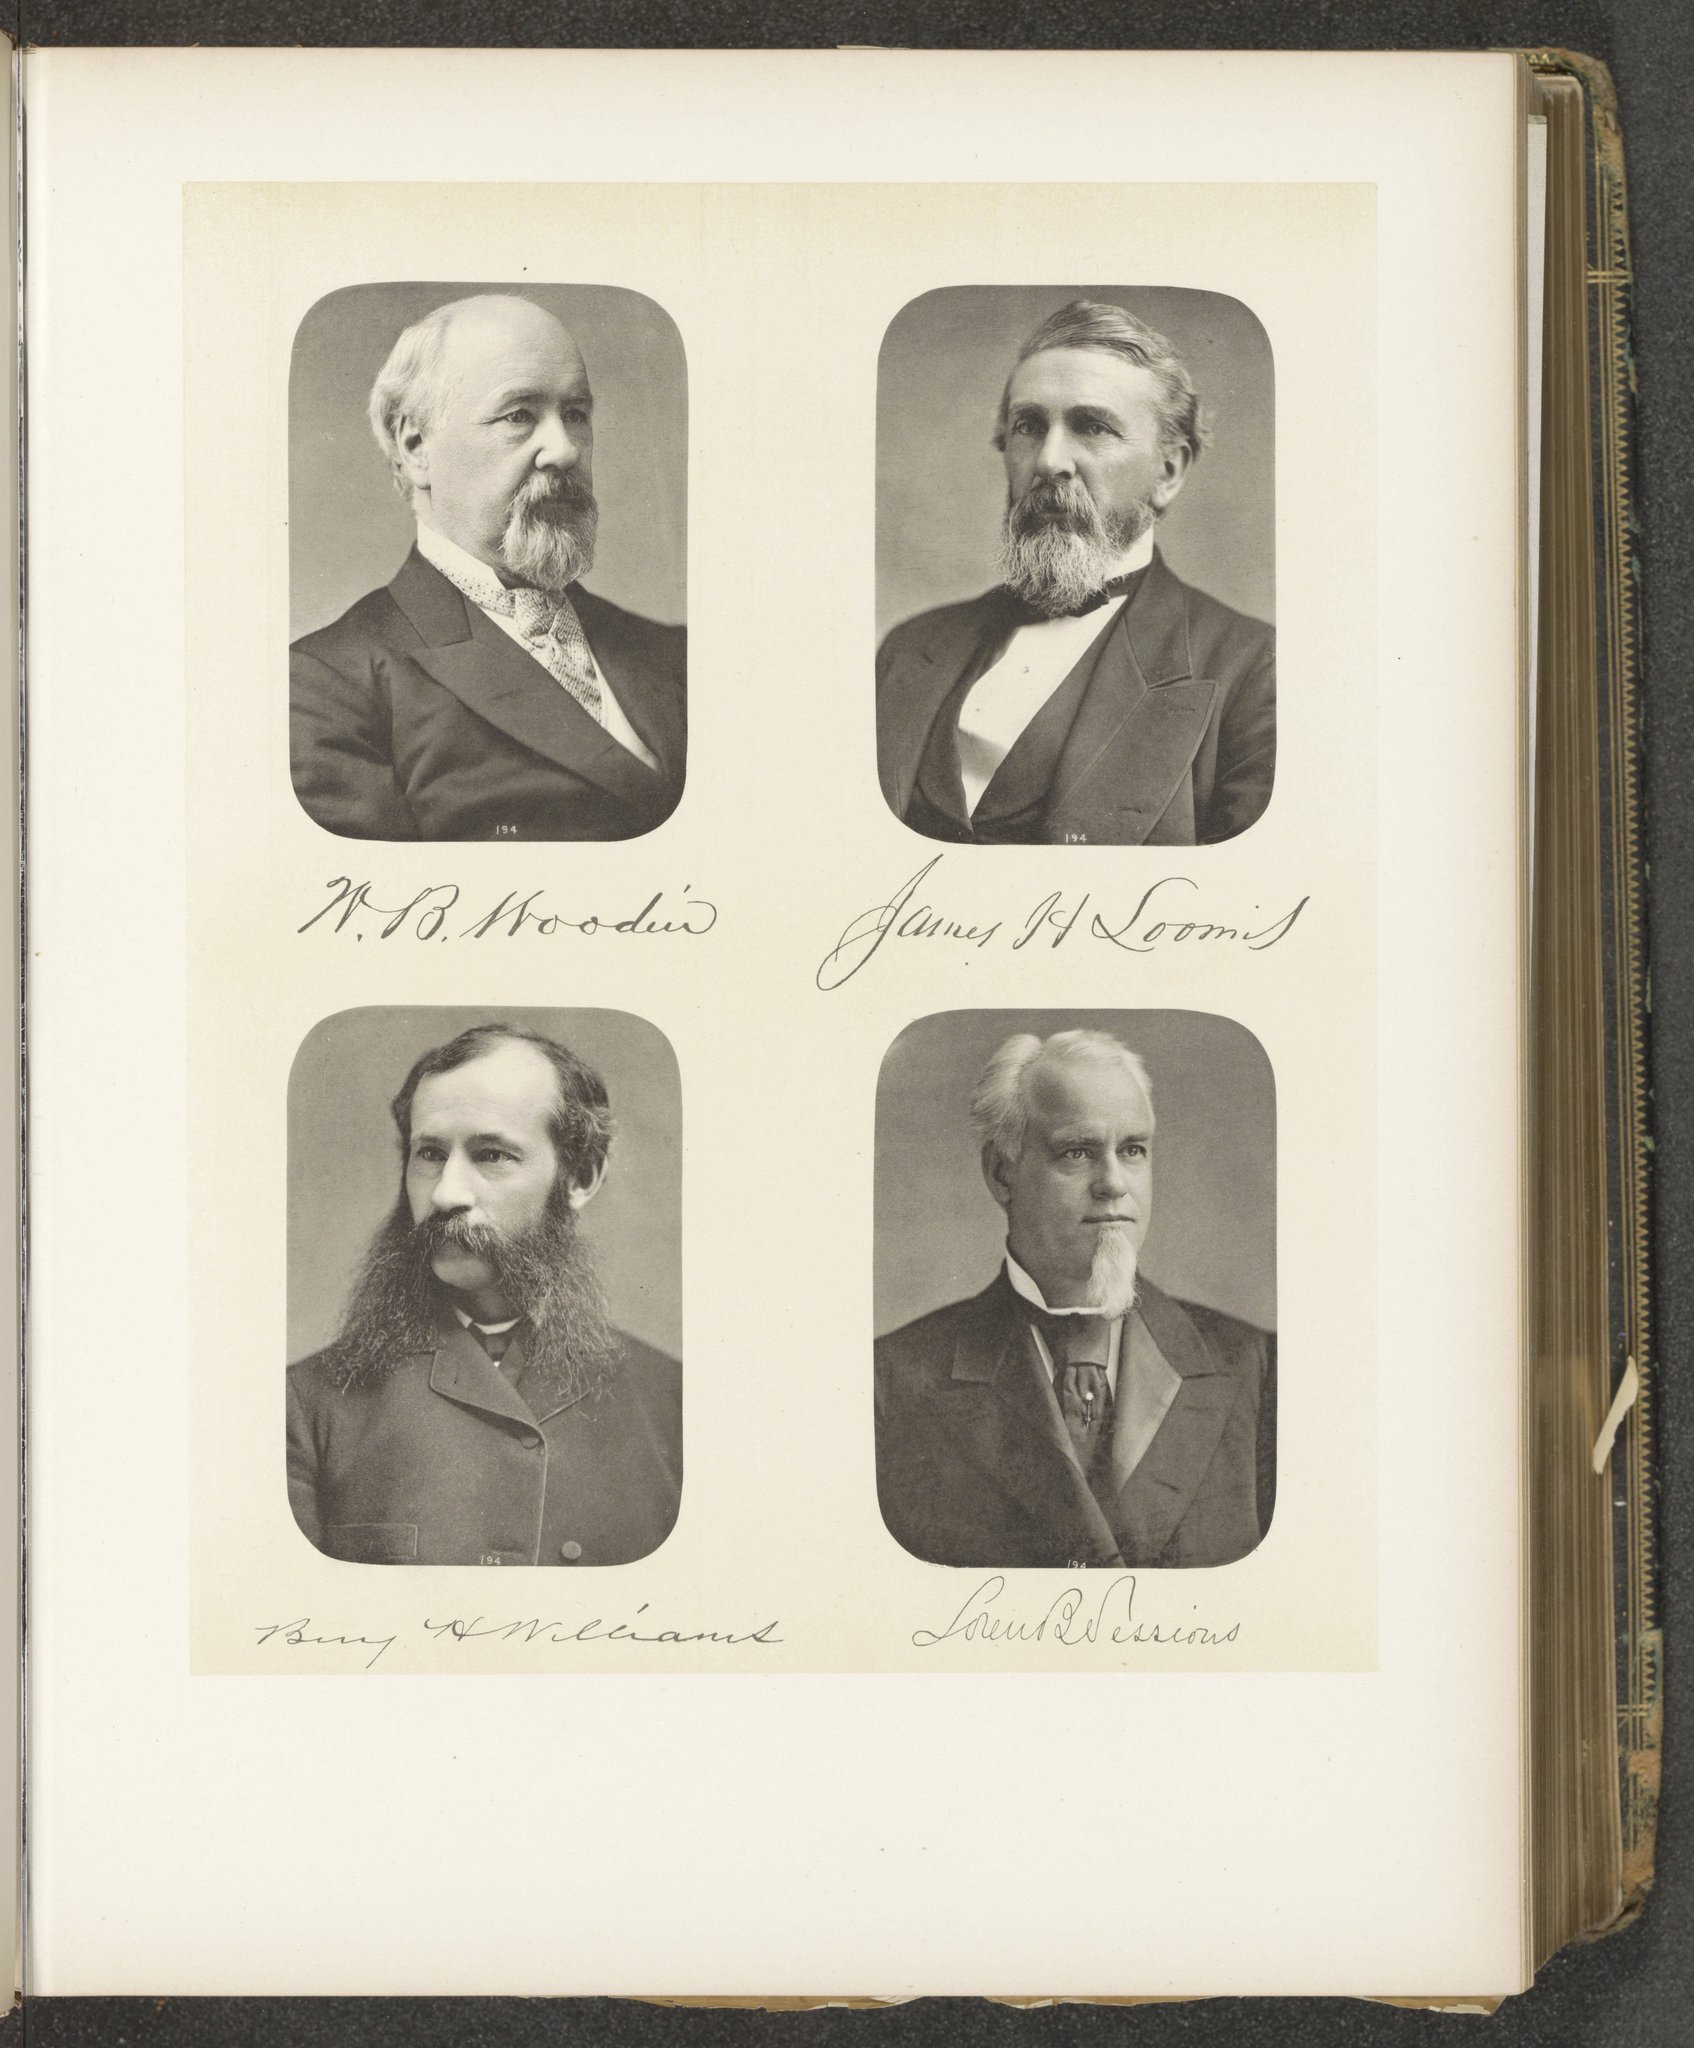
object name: photomechanical print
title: Portretten van vier Senaatsleden van de staat New York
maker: Anonymous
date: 1872-1882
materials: paper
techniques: photograph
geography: united states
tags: historical persons (portraits and scenes from the life) (+ head (and shoulders) (portrait))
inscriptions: annotation, number: ‘194’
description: Linksboven William B. Woodin, rechtsboven James Hervey Loomis, linksonder Benjamin H. Williams, rechtsonder Loren B. Sessions.